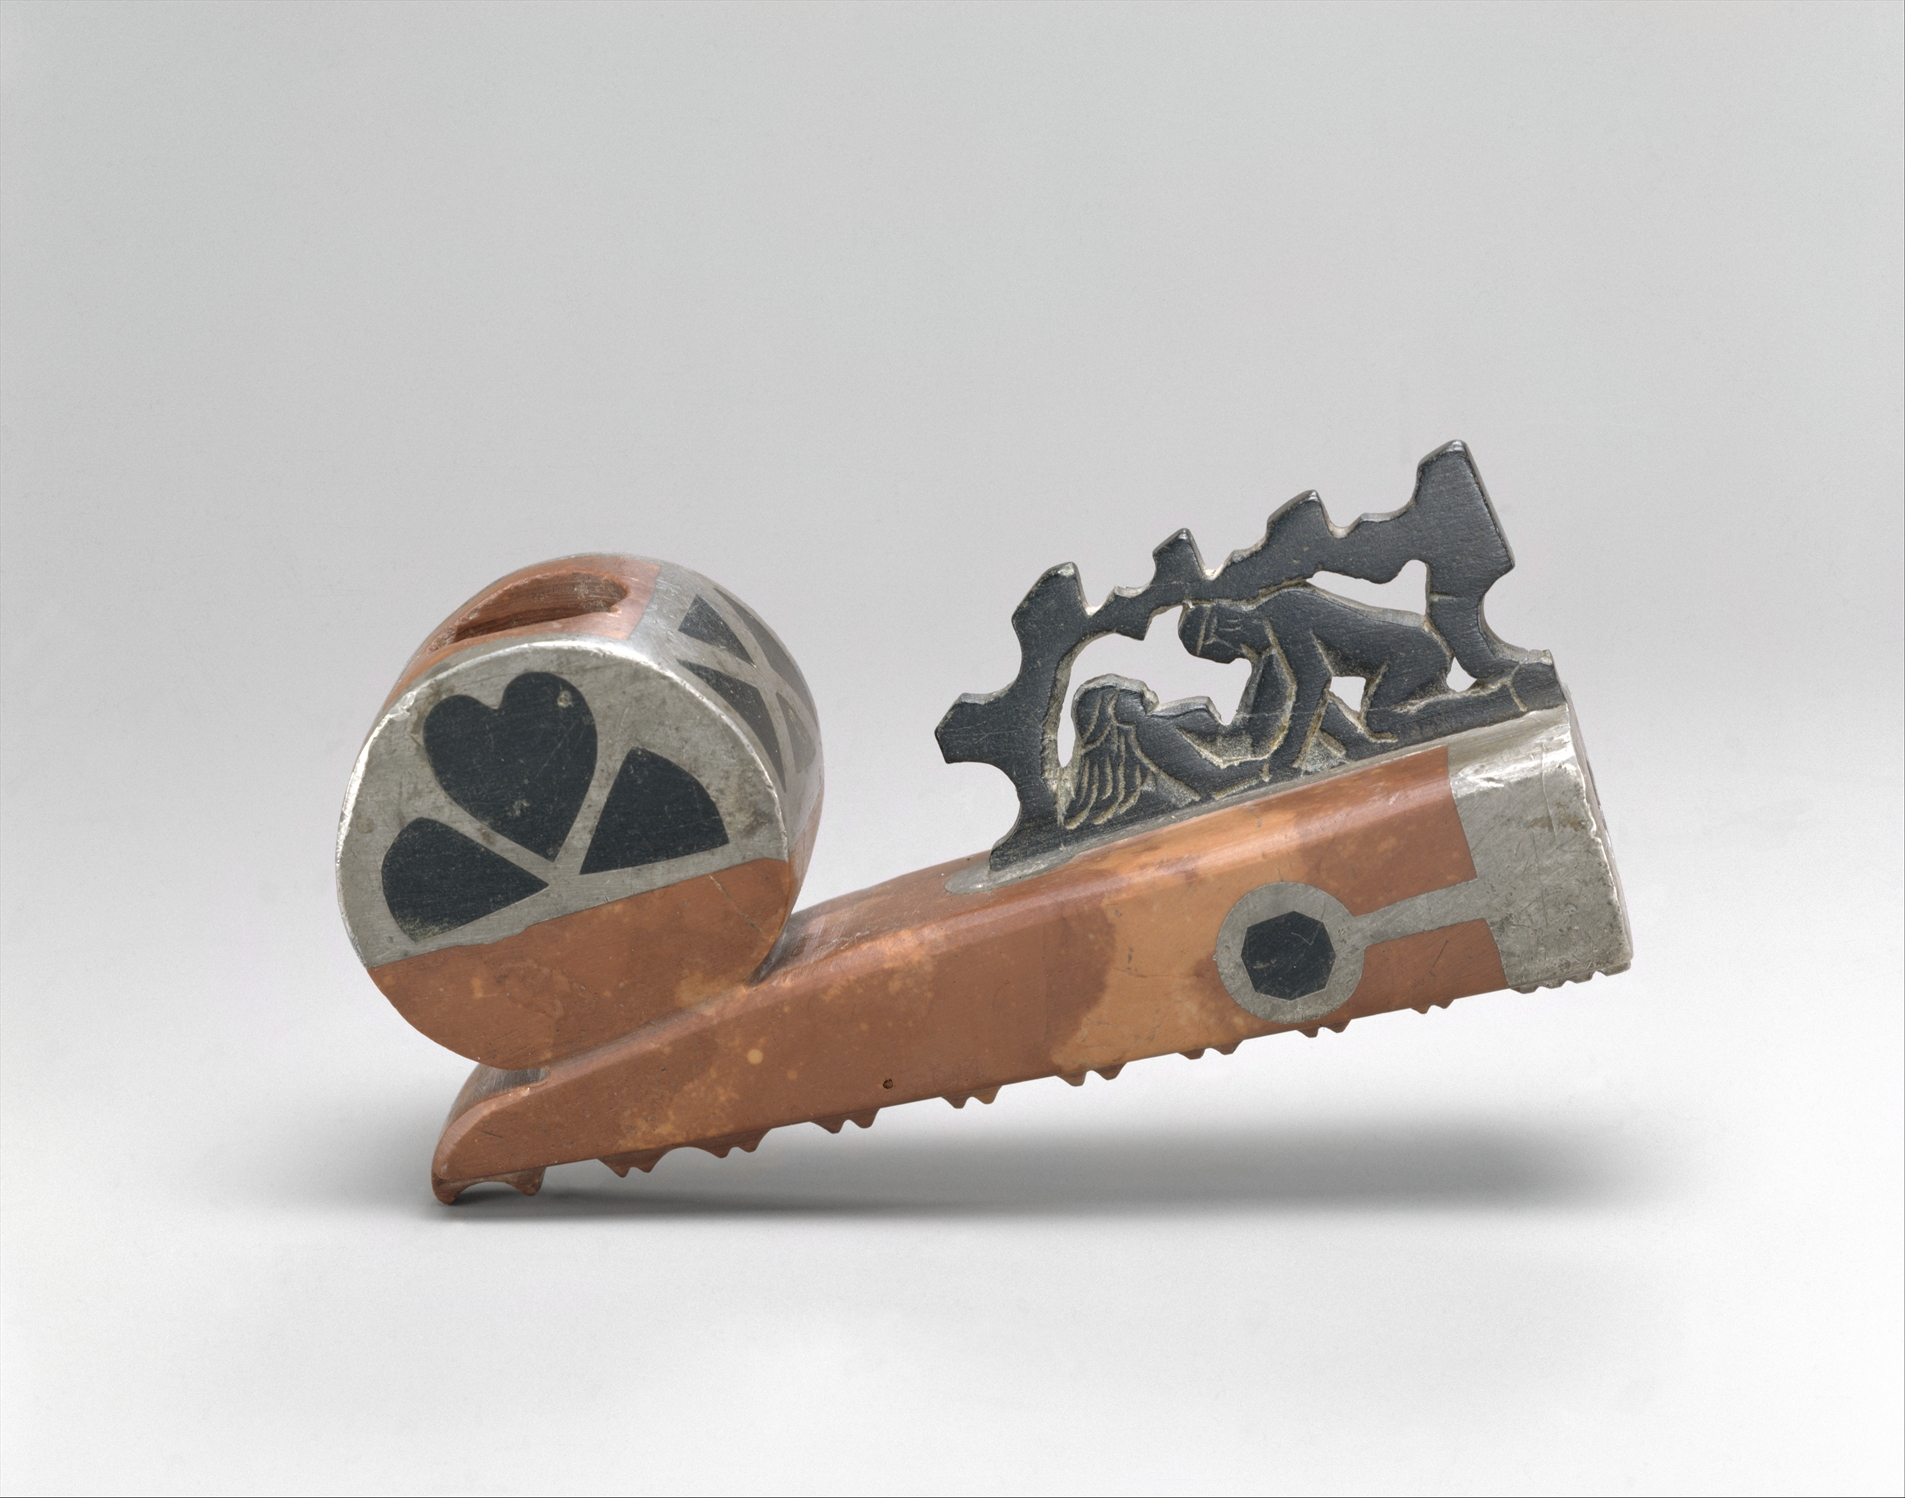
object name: pipe bowl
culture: eastern sioux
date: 1840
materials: metal, stone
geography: united states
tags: male nudes,female nudes